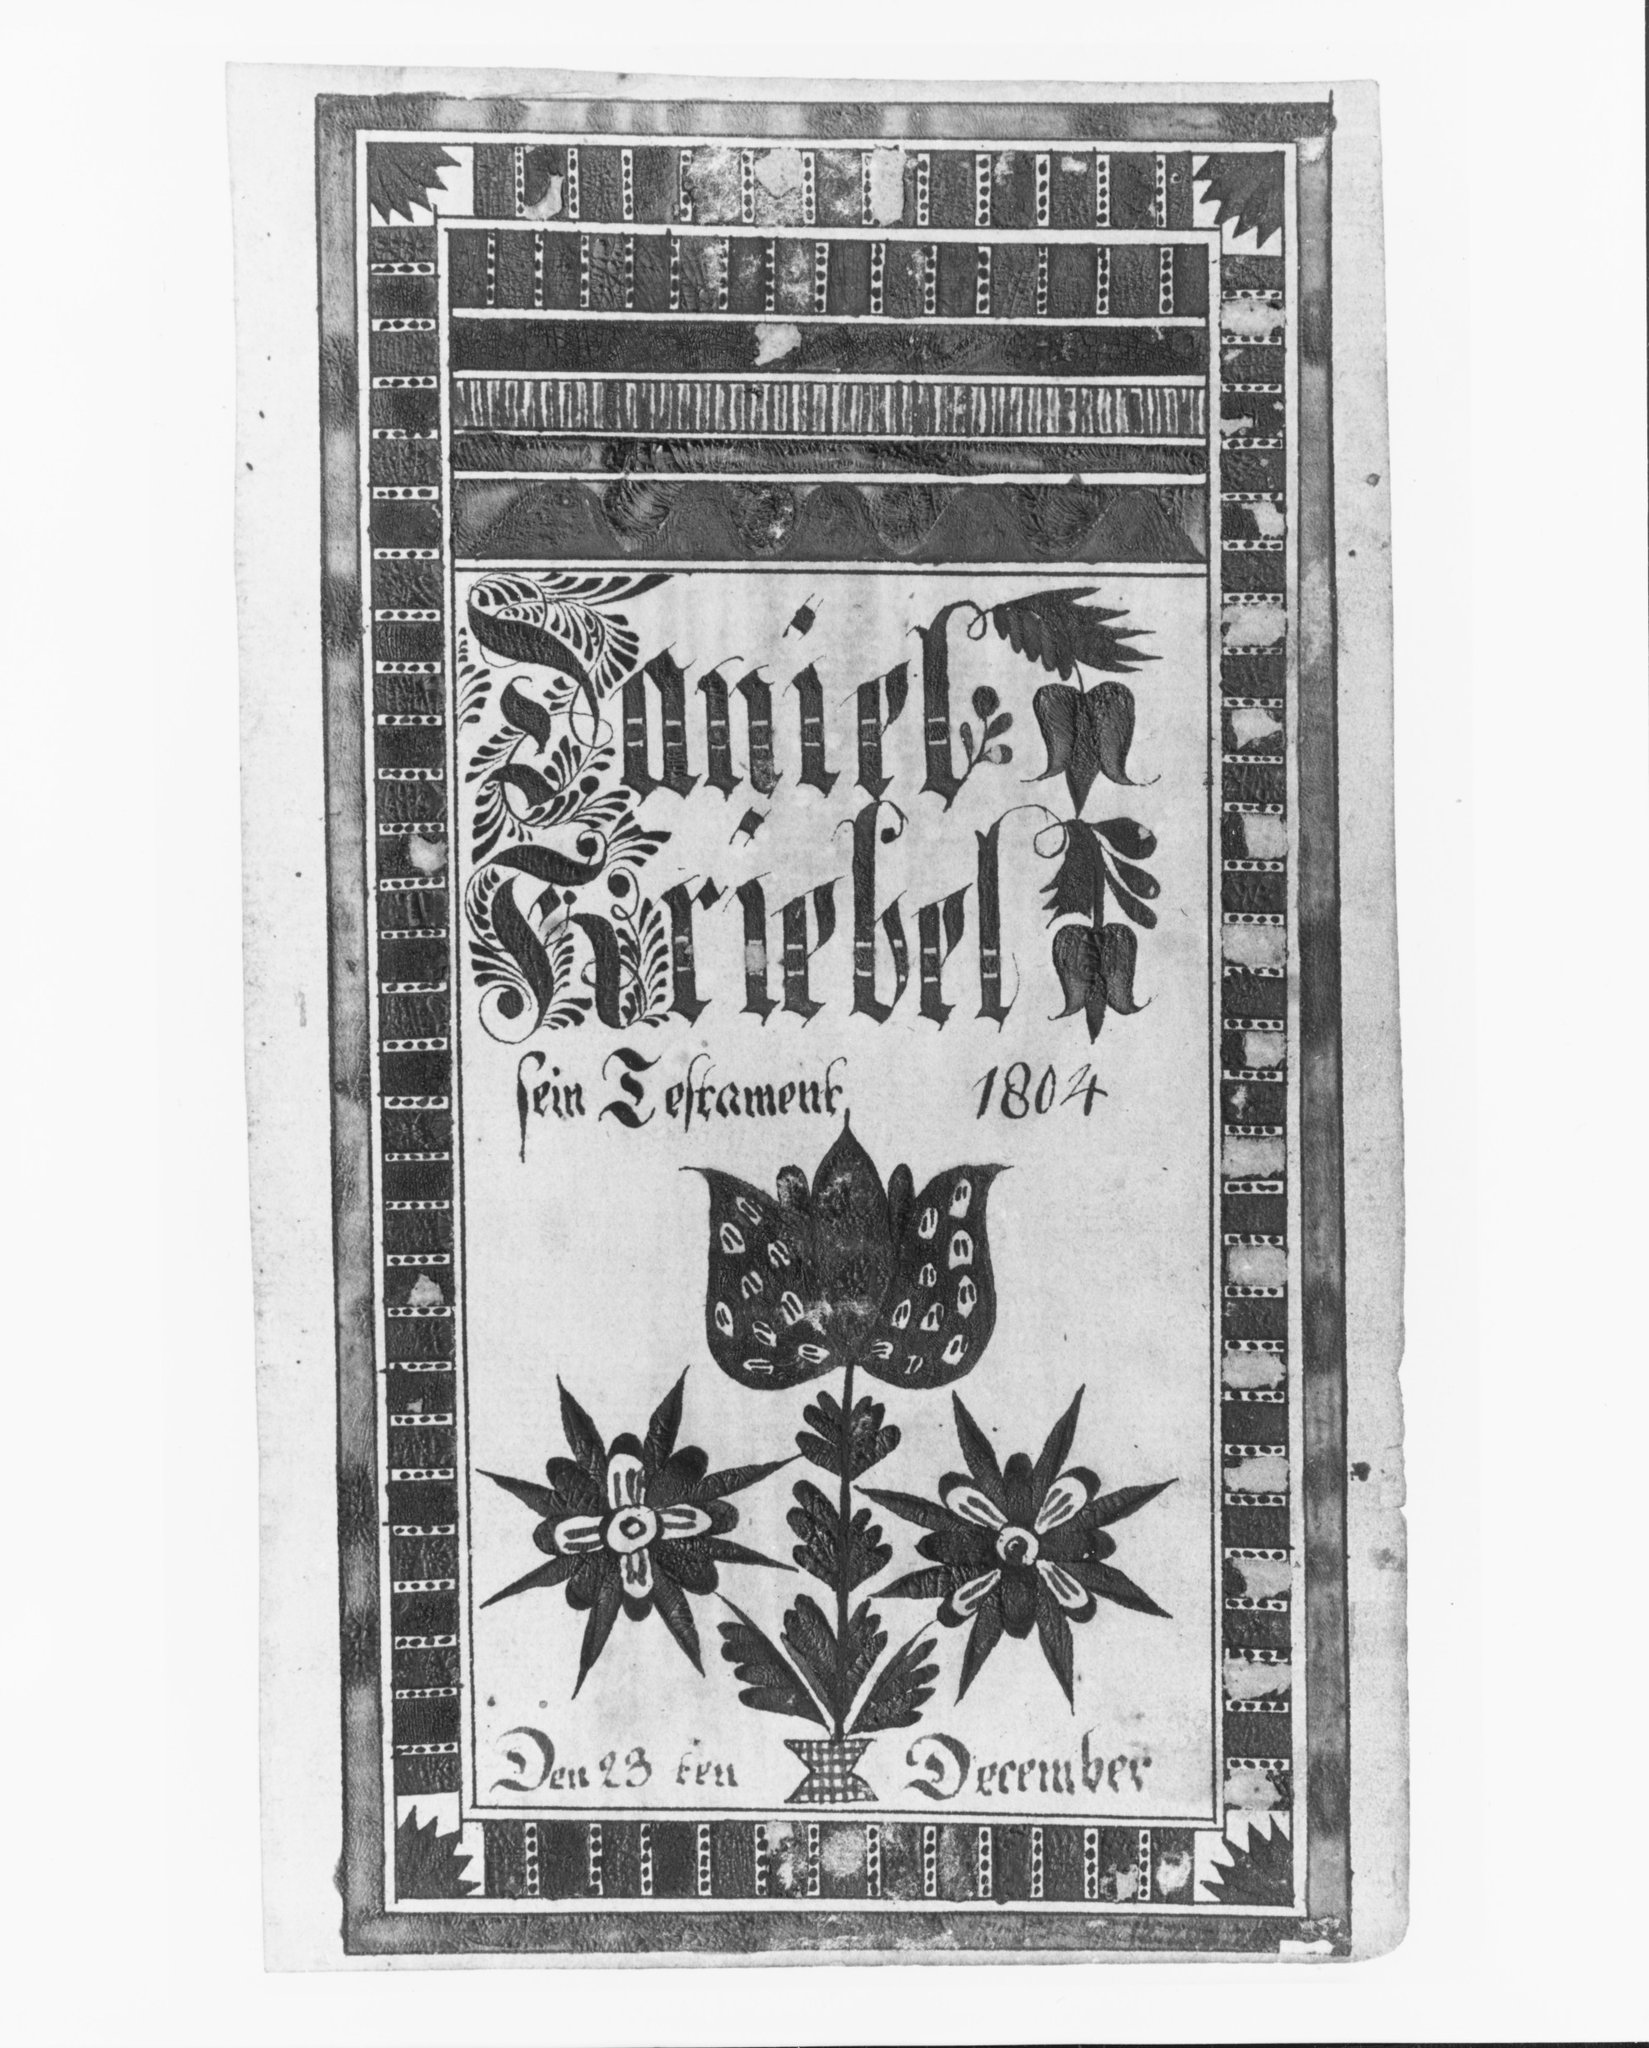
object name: flyleaf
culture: american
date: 1800-1830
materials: paper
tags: flowers